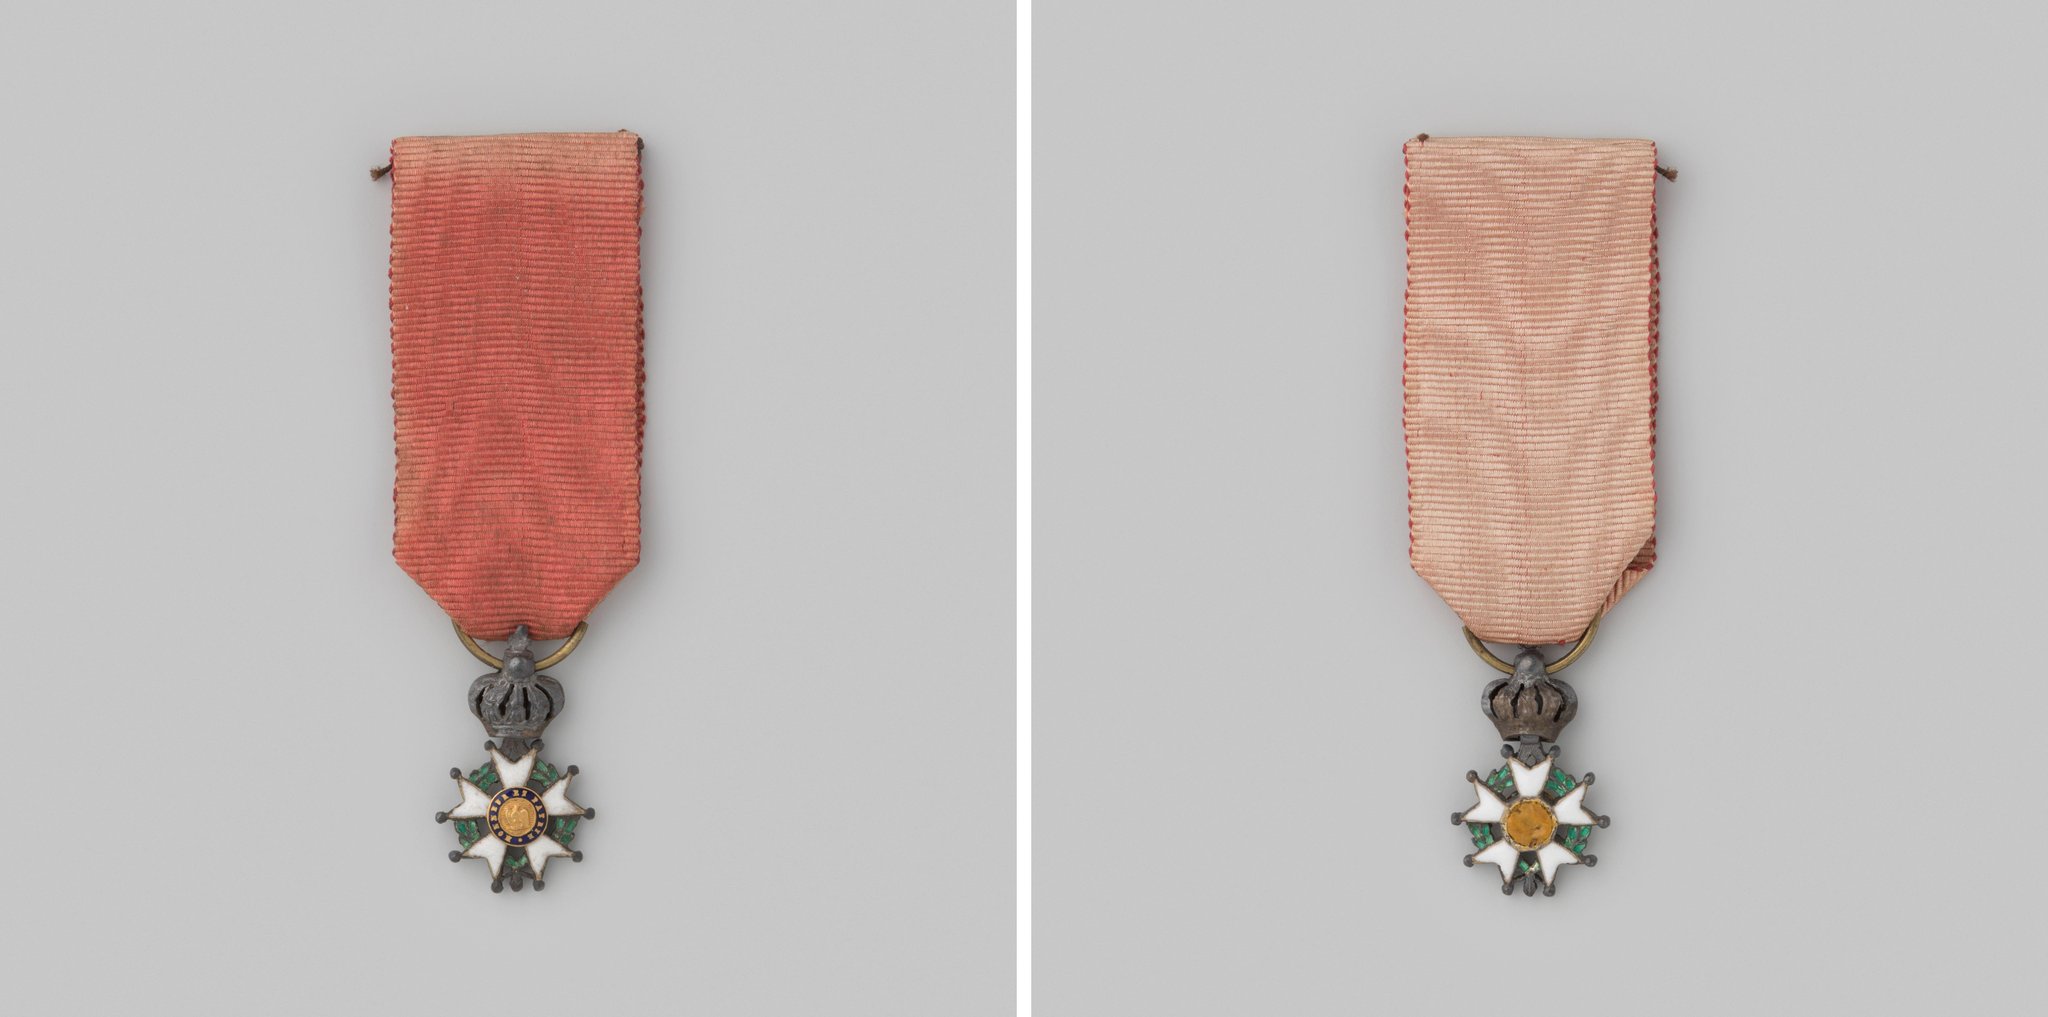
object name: history medal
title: Ridderkruis van het Legioen van Eer, toegekend aan generaal-majoor F.N.L. Aberson, commandant der schutterij te Amsterdam wegens deelname aan 17 veldtochten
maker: Anonymous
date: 1802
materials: metal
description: Ereteken en draagpenning met oog, ring en lint, klein model.